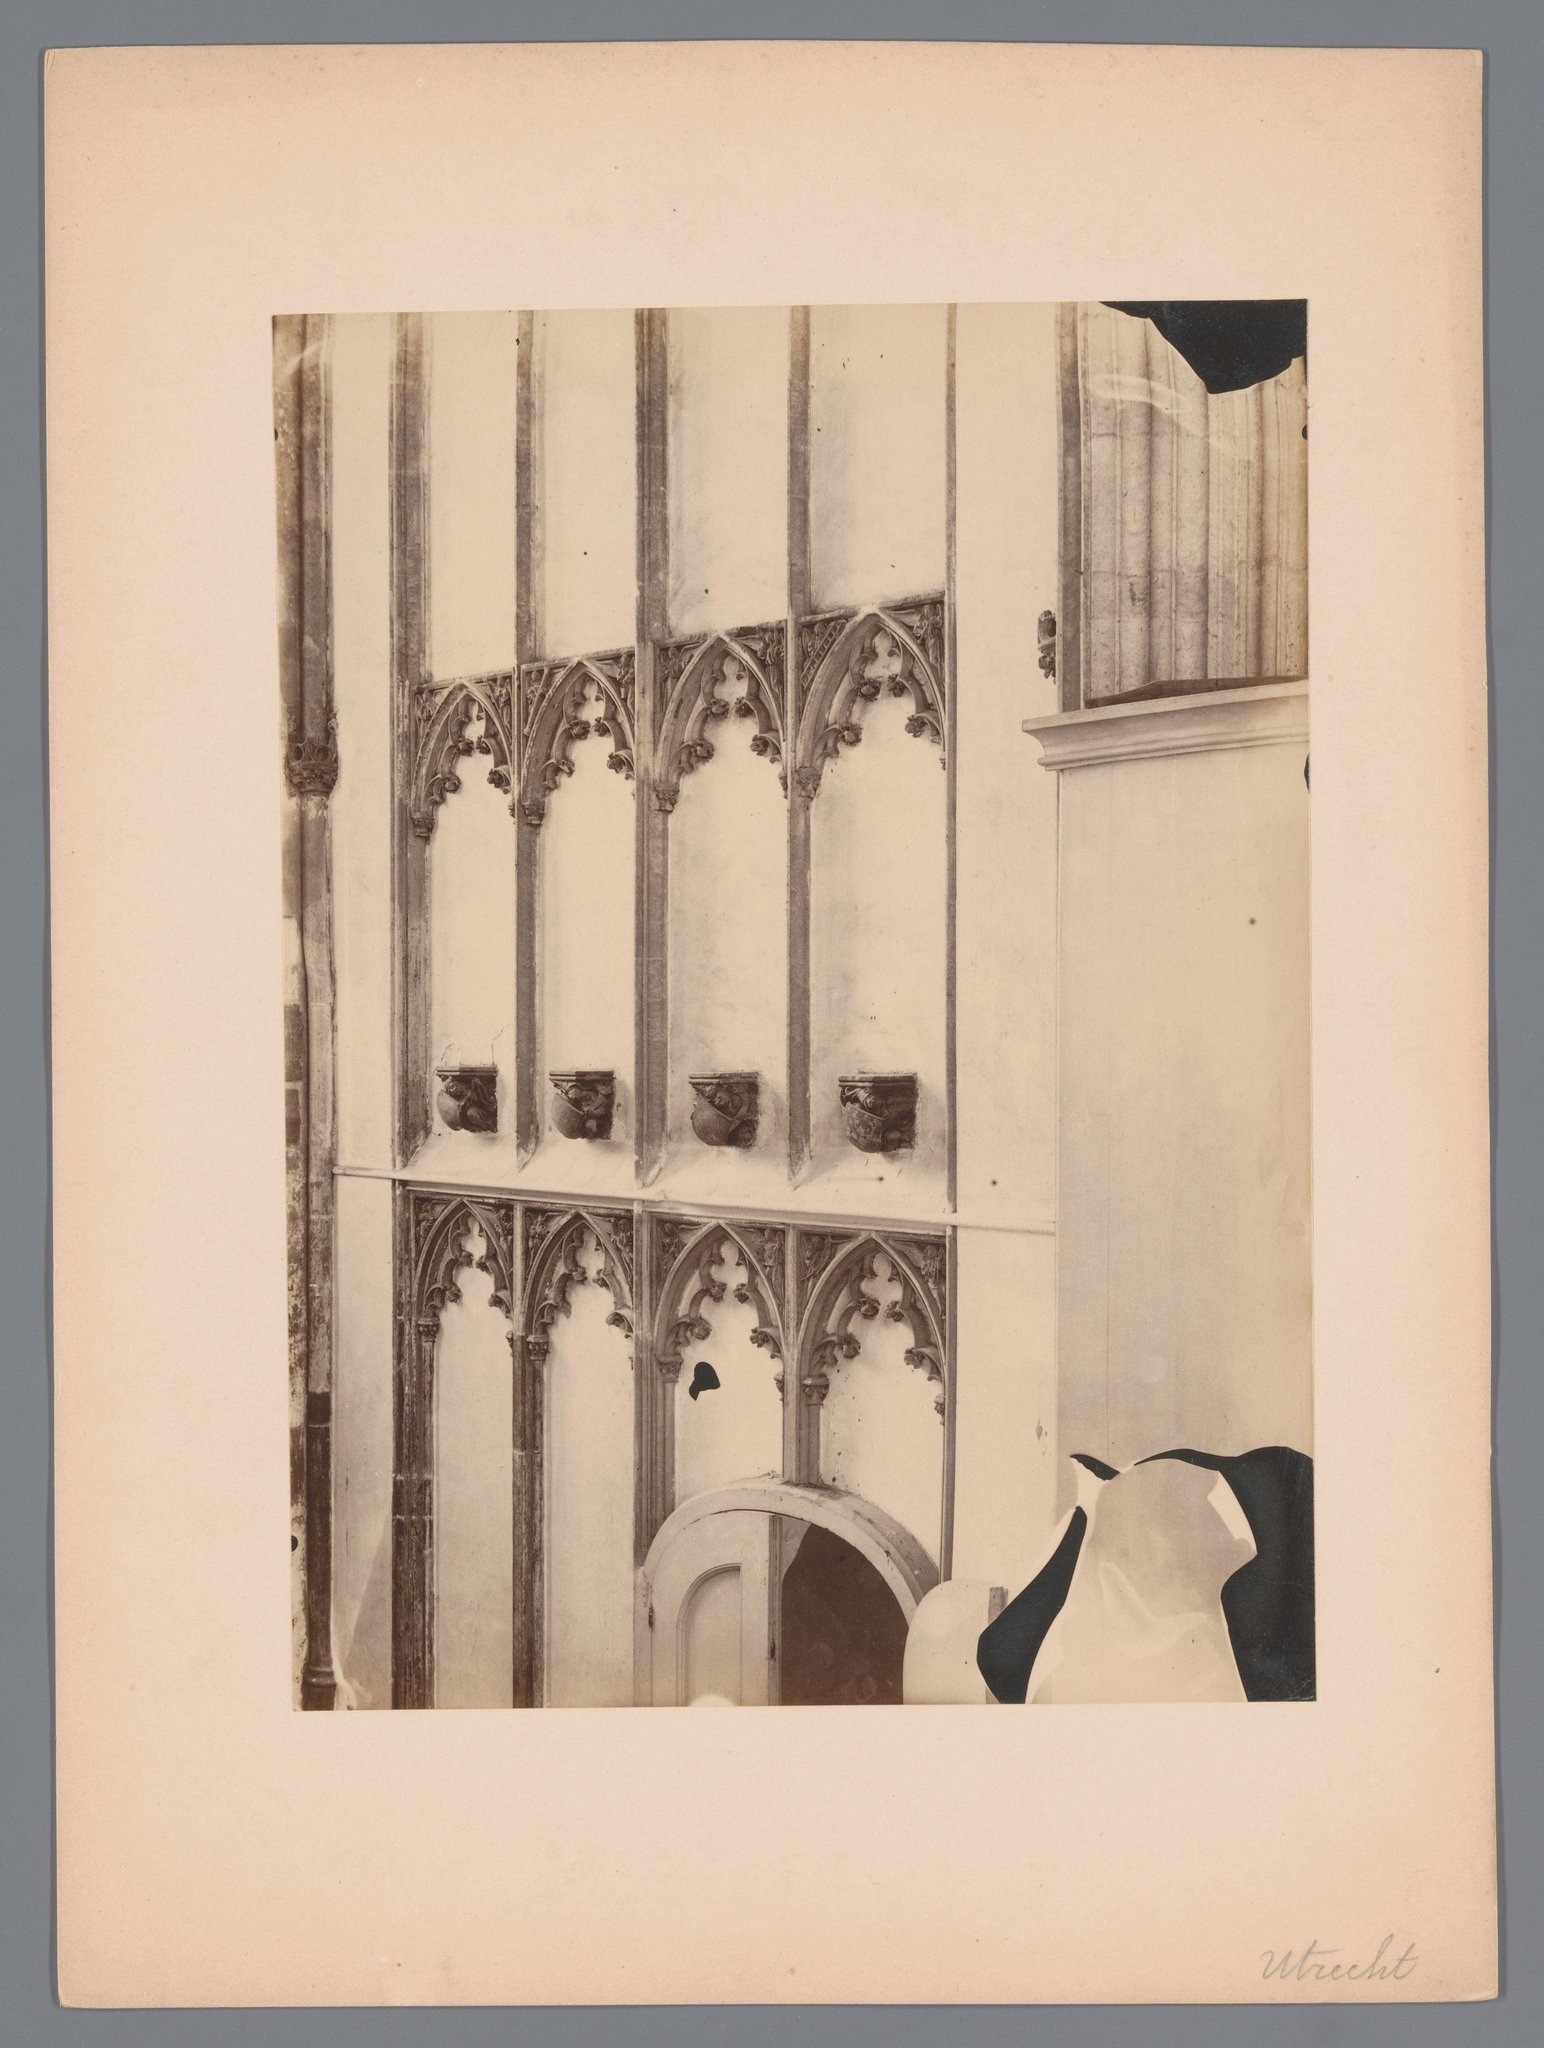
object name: photograph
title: Details in de kapel van de Dom van Utrecht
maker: anoniem (monumentenzorg)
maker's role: fotograaf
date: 1891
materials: cardboard, photographic support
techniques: albumen print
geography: utrecht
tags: interior of church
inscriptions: annotation: ‘Utrecht’, annotation: ‘Domkerk te Utrecht/ sept 1891/ Wandversiering in de grafkapel van Bisschop Rudolf van [...]’